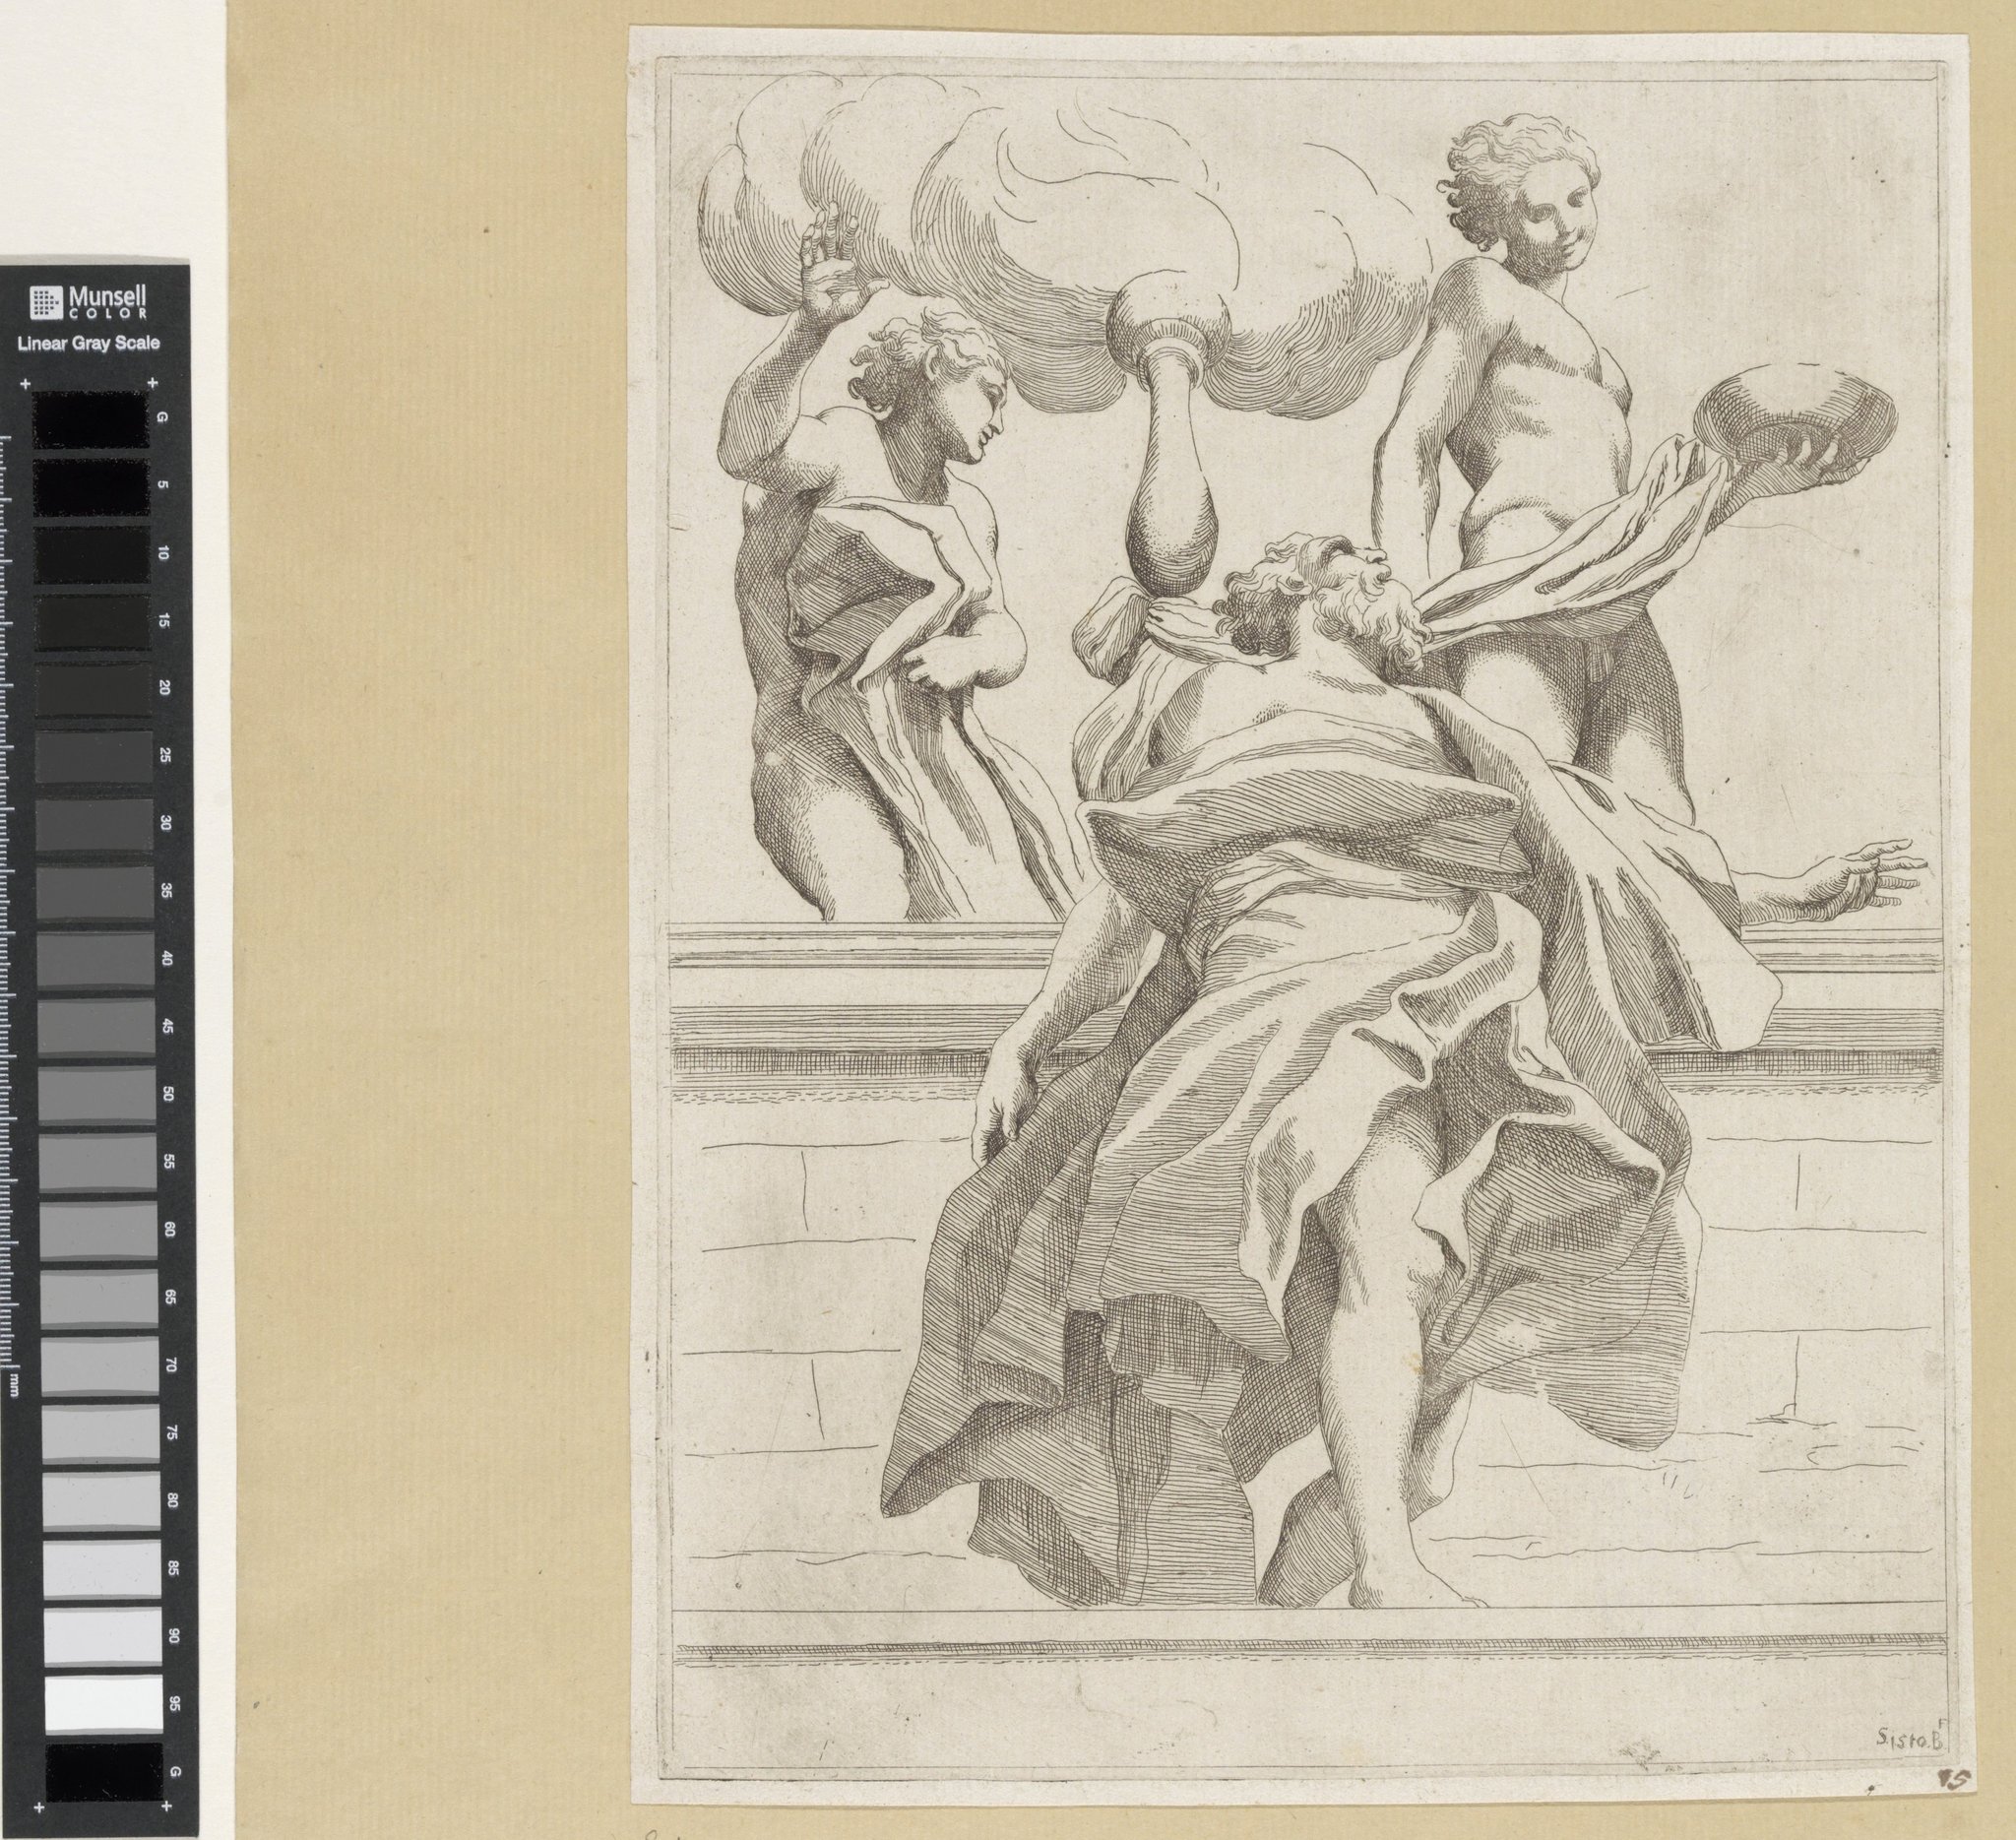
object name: print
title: Koepeldecoraties door Correggio in de S. Giovanni Evangelista in Parma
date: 1591-1647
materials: paper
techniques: etching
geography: parma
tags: prophets, sibyls, evangelists, doctors of the church; persons ~ the bible (not in biblical context), angels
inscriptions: collector's mark: Lugt 10, number: ‘15’, collector's mark: Lugt 11, collector's mark: ‘Hinloopen’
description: Een profeet staande voor een balustrade. Op de balustrade staan twee jonge naakte figuren (engelen?).